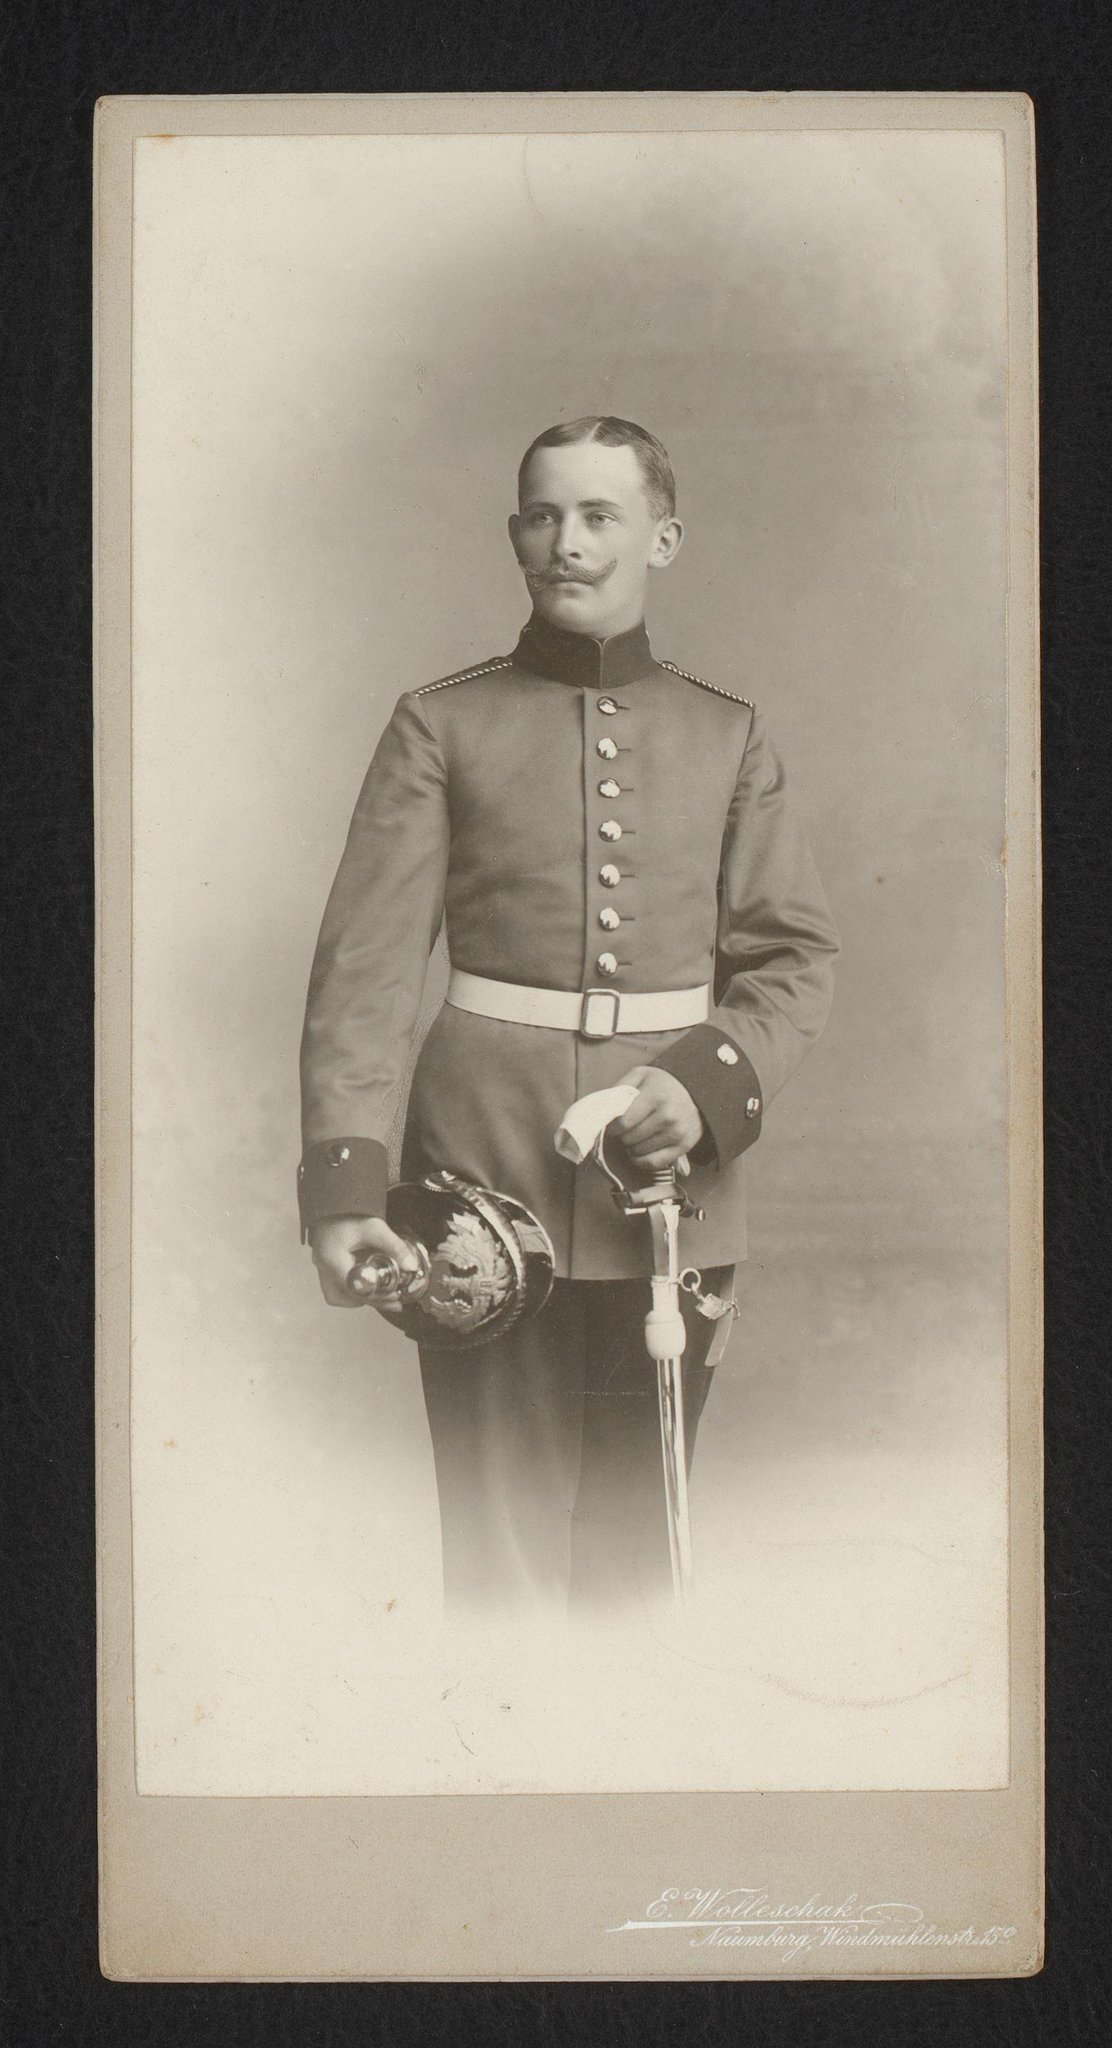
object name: photograph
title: Portret van een staande man in militair uniform met sabel en helm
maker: e. wolleschak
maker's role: fotograaf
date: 1901-1920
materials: cardboard, photographic support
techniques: matte daylight collodion silver print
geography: naumburg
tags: helmet, hacking and thrusting weapons (with name), historical persons, (military) uniforms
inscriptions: inscription: ‘PRÄMIIRT/ WEIMAR 1901./ E. Wolleschak/ Photogr. Kunst-Anstalt/ NAUMBURG a/S./ Windmühlenstr. 15 c./ Nähe Jägerplatz/ Die Platten bleiben für Nachbestellungen aufbewahrt./ Vergrösserungen selbst nach alten vergilbten Bildern/ unter Garantie der grössten Aehnlichkeit.’